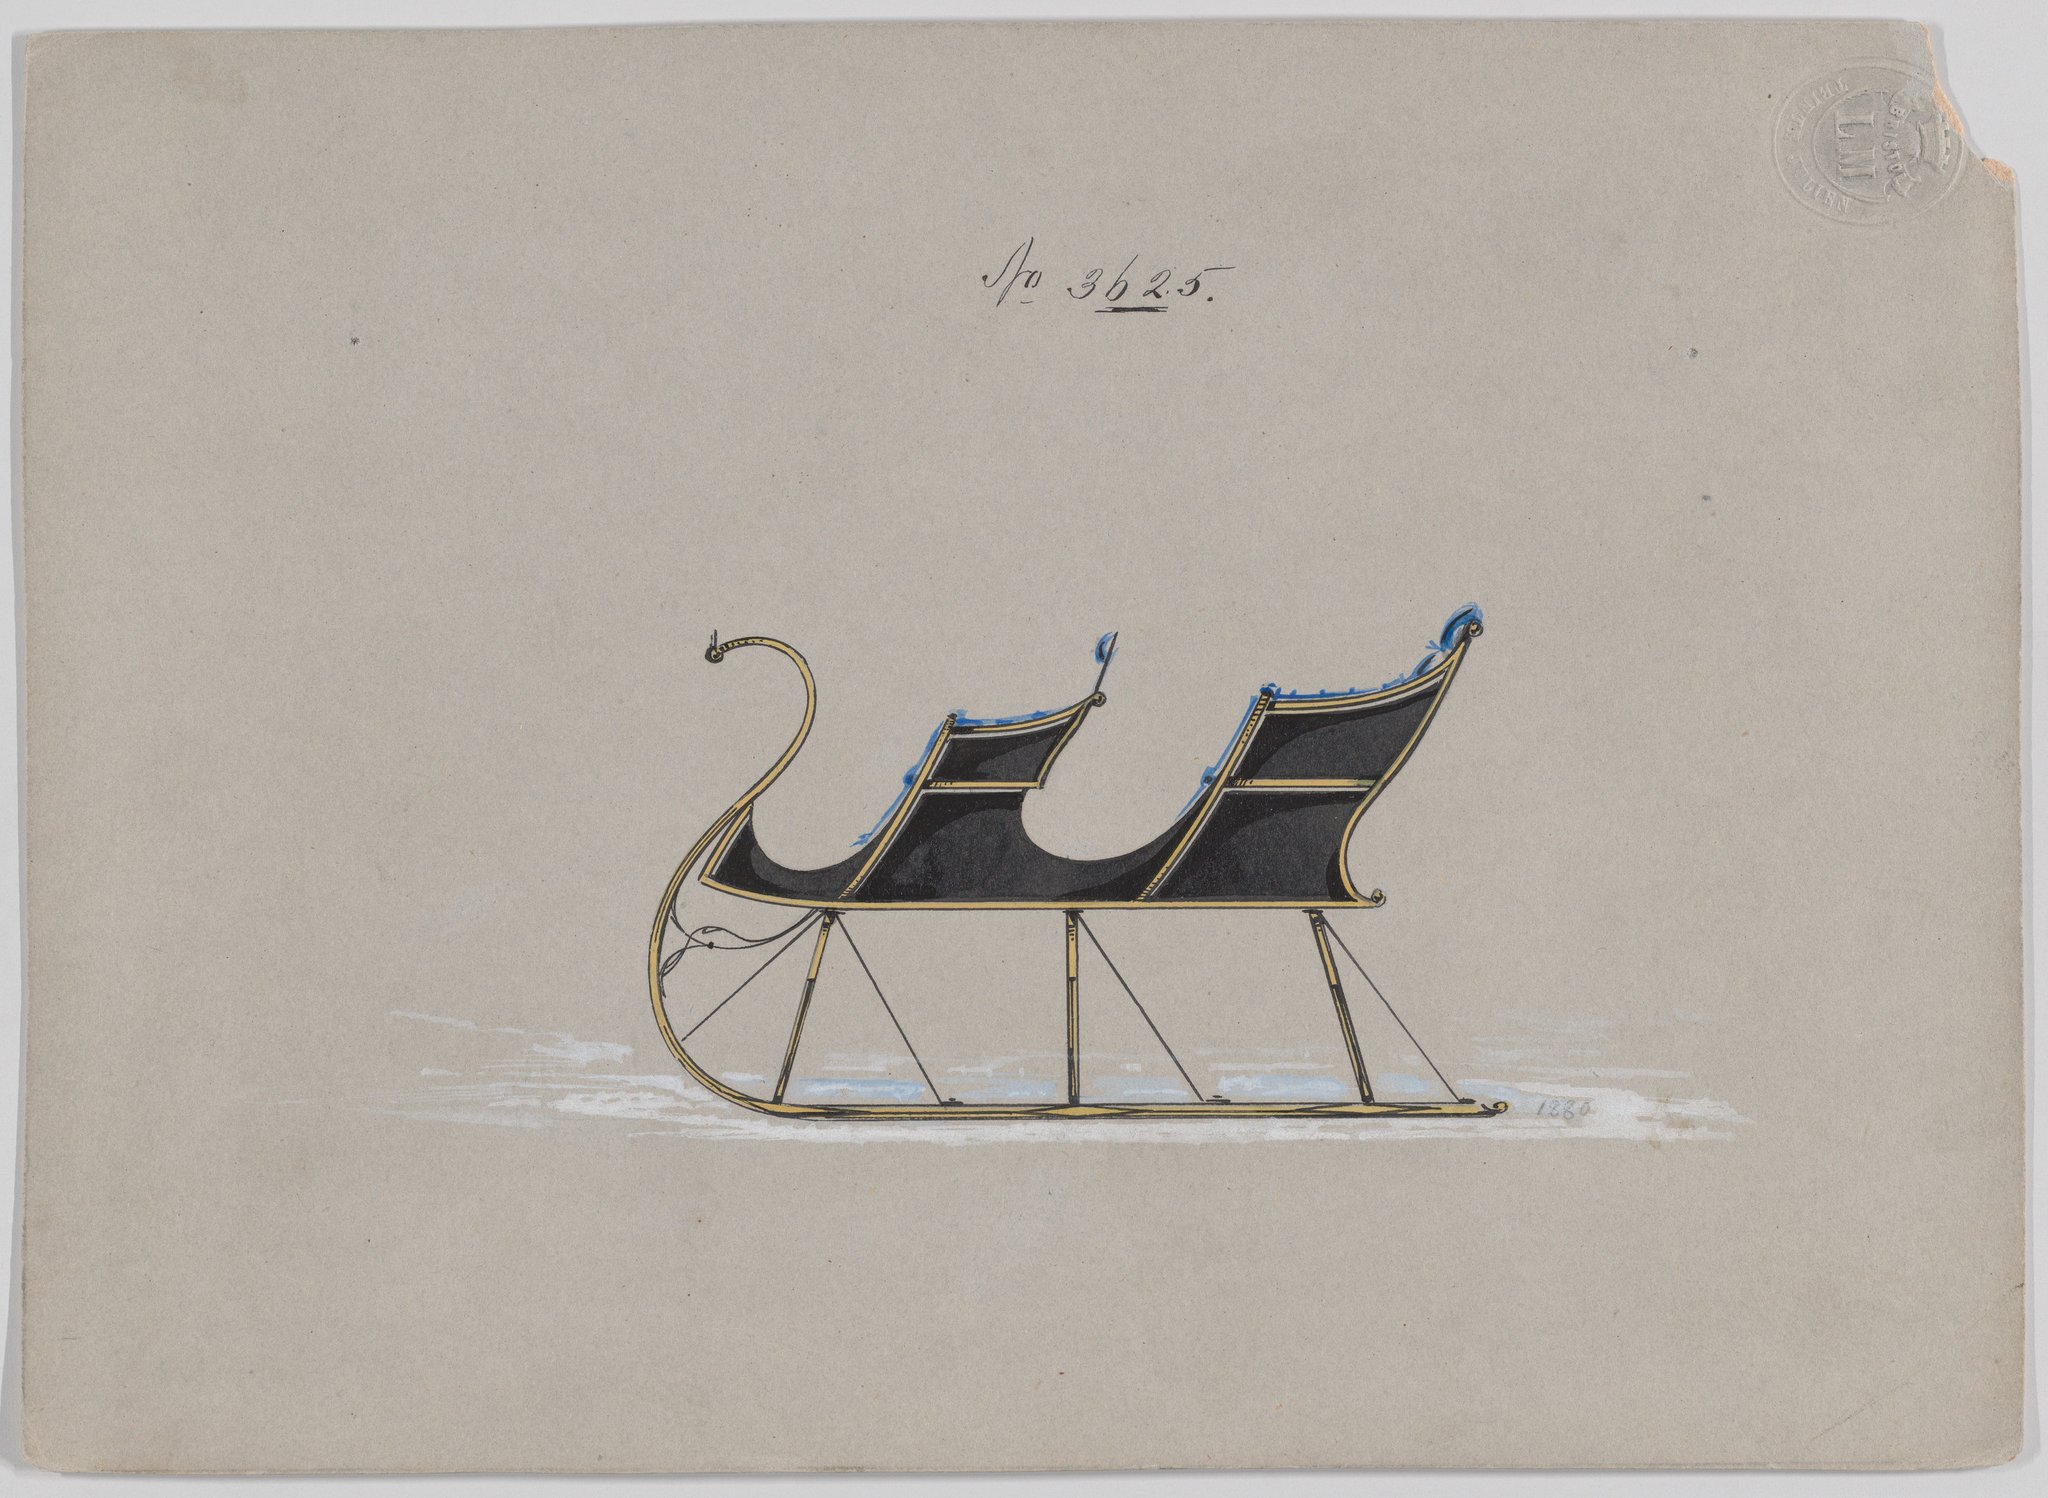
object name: drawing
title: Design for 4 Seat Sleigh, no. 3625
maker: brewster & co.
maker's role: manufacturer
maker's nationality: american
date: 1880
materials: gouache, gum arabic, ink, watercolor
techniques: pen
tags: sleighs